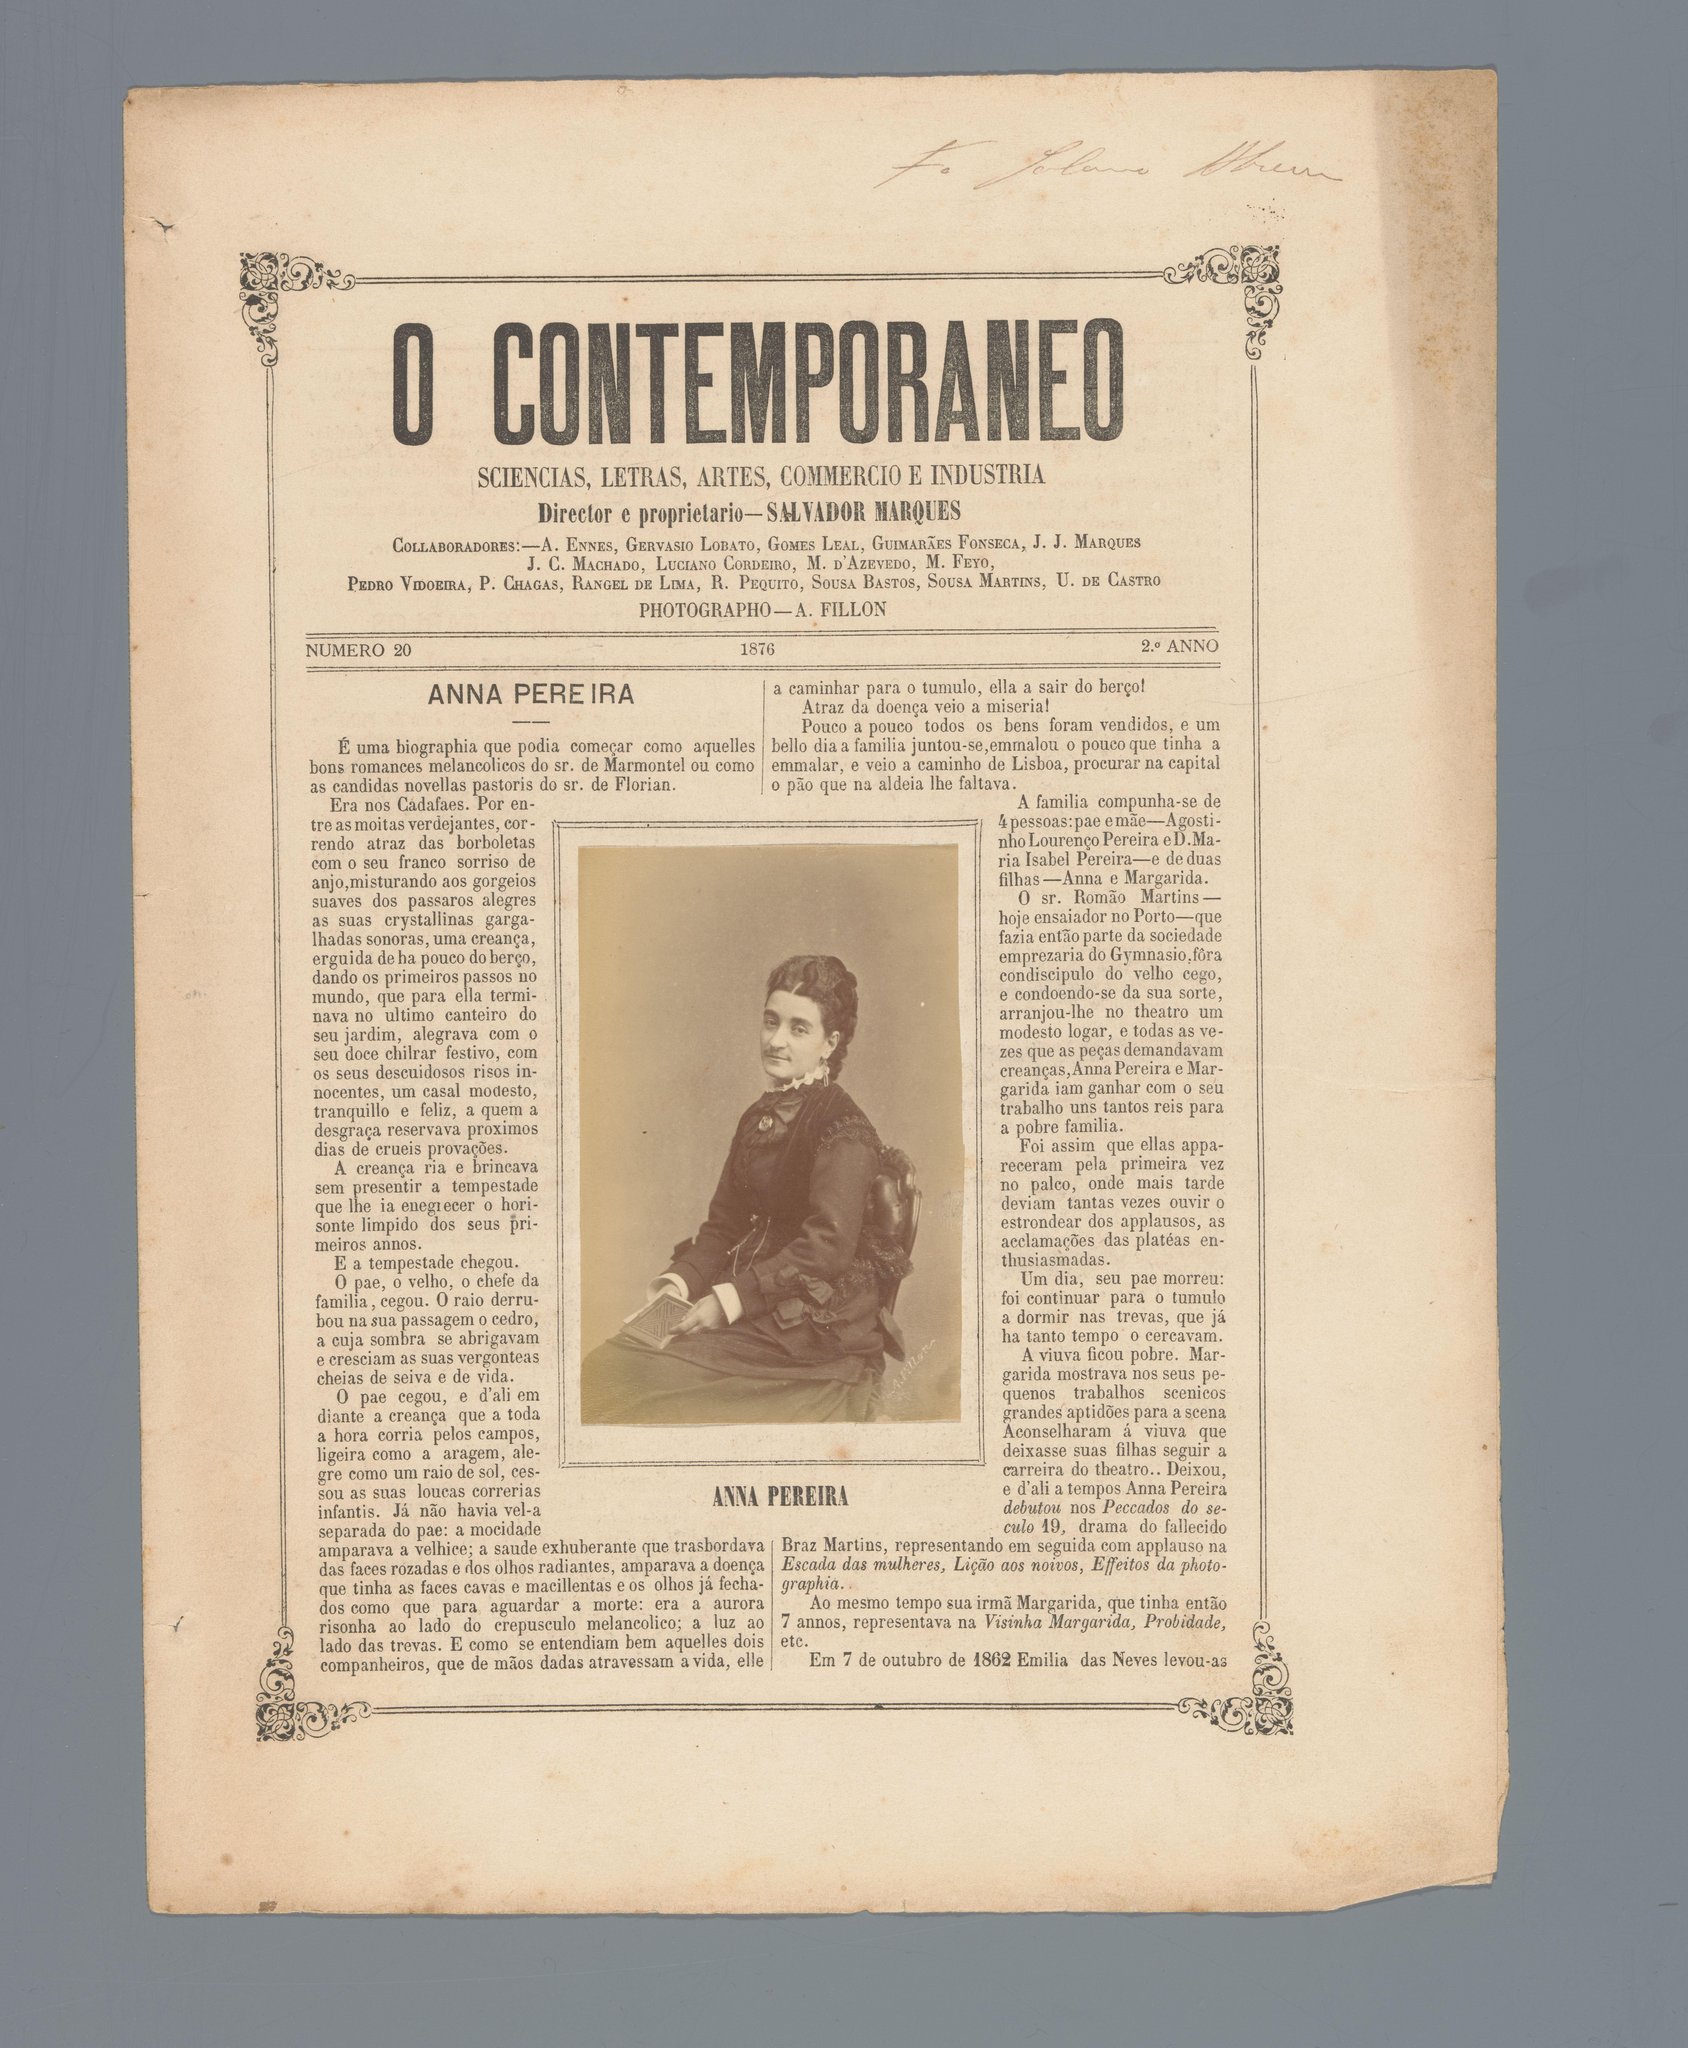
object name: photograph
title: O contemporaneo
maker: alfred fillon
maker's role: fotograaf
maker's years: 1825-1881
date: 1871-1876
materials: paper, photographic support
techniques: albumen print, printing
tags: historical persons - bb - woman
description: Op de voorpagina bevindt zich een portret van Anna Pereira.